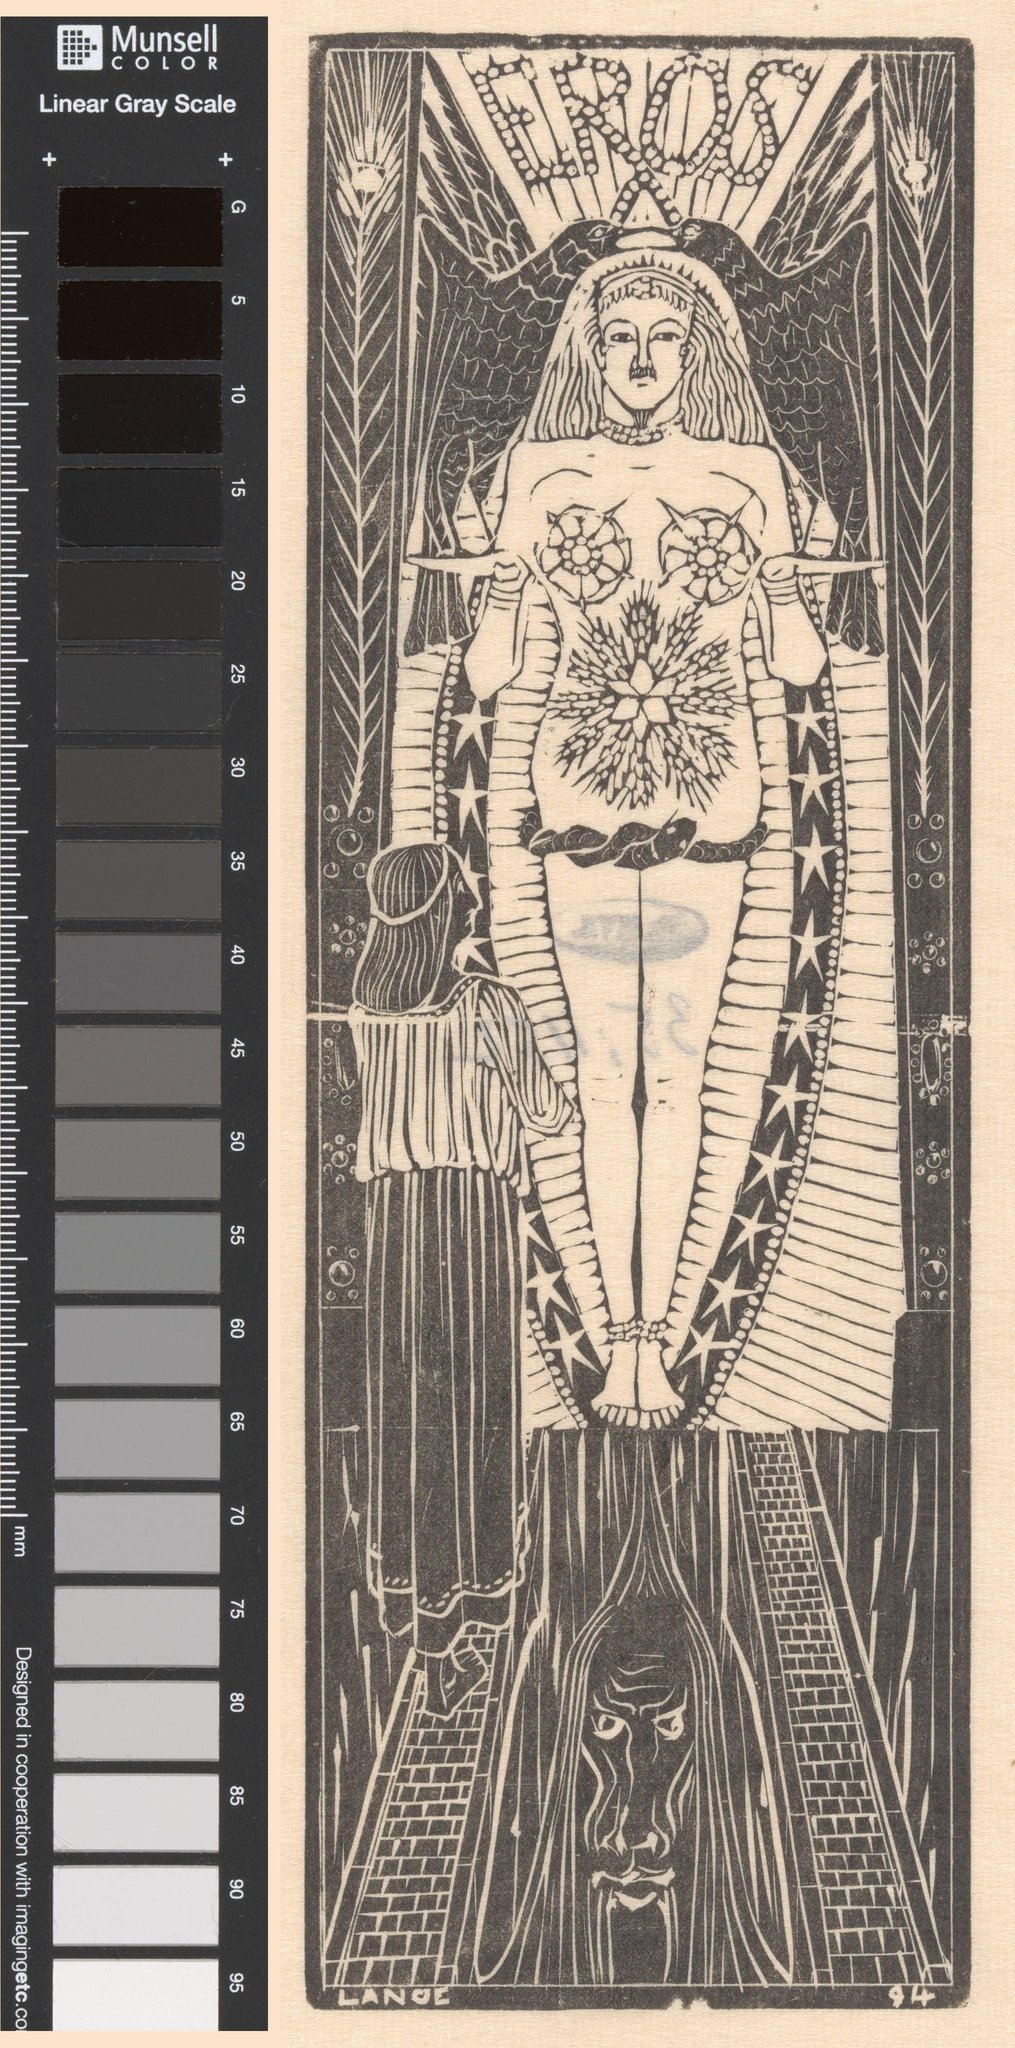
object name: illustration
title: Zwevende figuur met twee roofvogels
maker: mathieu lauweriks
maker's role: designer, draughtsman, print maker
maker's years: 1864-1932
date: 1894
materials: paper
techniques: woodcut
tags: snakes, beard - aa - ~ women, woman (showing herself) undressed, quasi-nude, predatory birds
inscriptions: collector's mark: Lugt 2228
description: Een androgyn figuur zweeft boven een kloof met twee smalle bruggen. Op de handen zitten twee roofvogels en om het middel zit een slang. Bovenaan het woord 'Eros'. Links op een van de bruggen staat een vrouw naar de figuur te kijken.